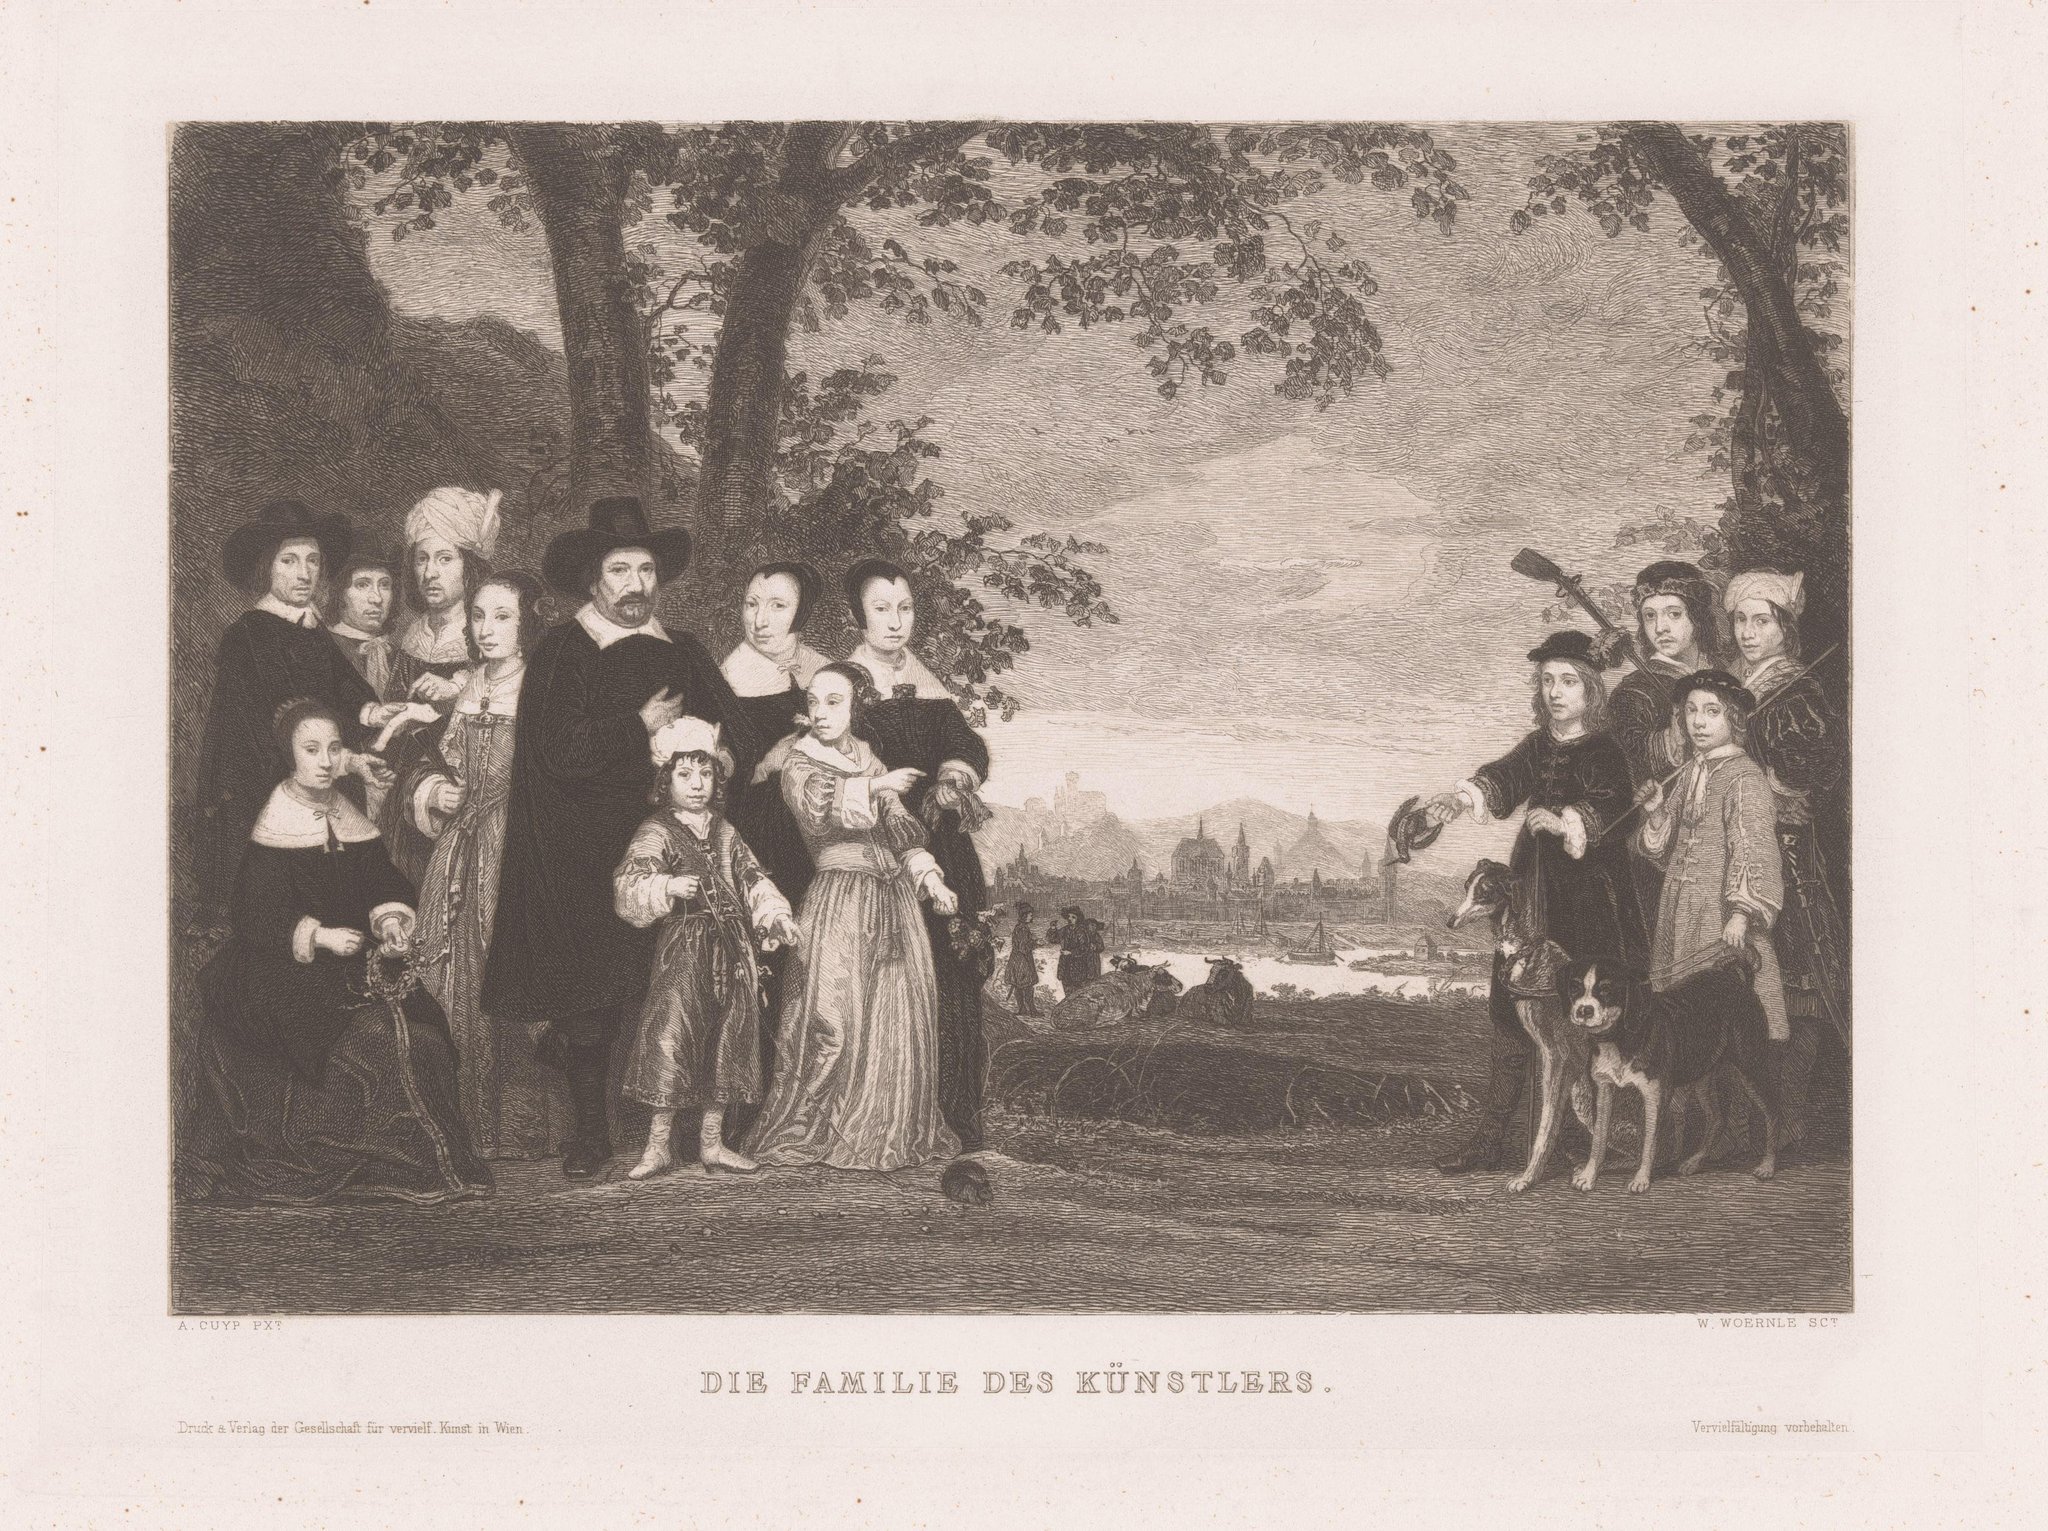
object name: print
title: Familieportret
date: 1859-1916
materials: paper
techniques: etching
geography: vienna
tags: city-view, and landscape with man-made constructions, group-portrait of hunters, parents with their children, hunting dogs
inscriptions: collector's mark: Lugt 2228